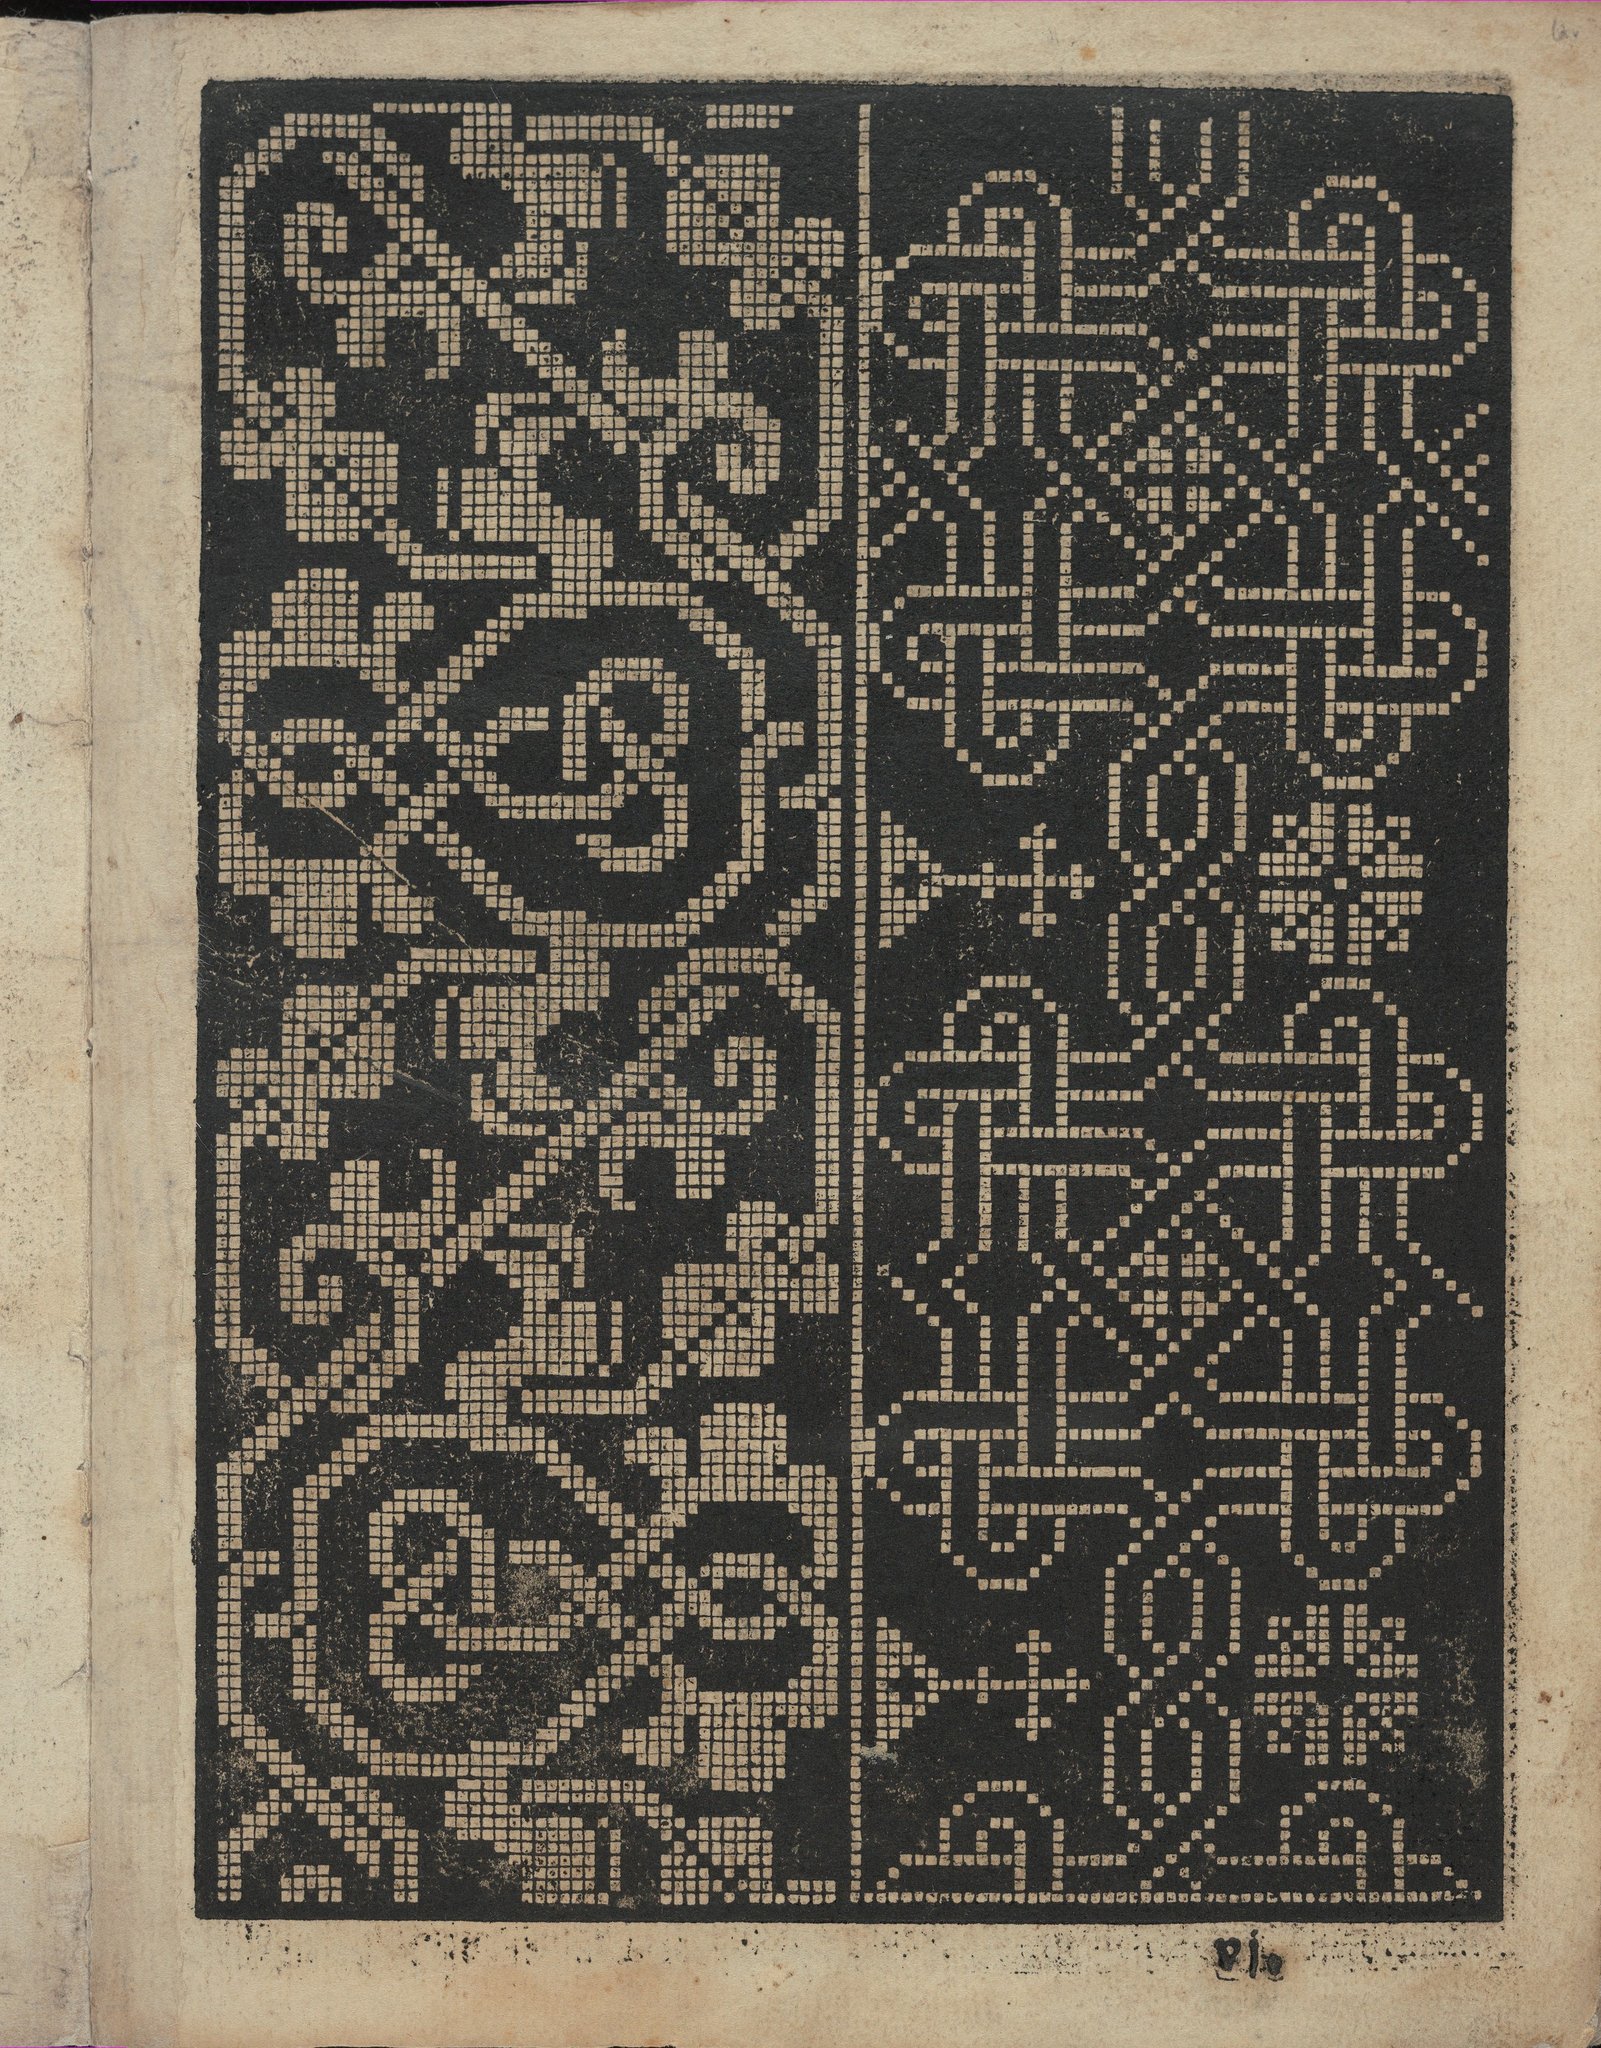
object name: book print ornament architecture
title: Libbretto nouellamete composto per maestro Domenico da Sera...lauorare di ogni sorte di punti, page 6 (recto)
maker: domenico da sera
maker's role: publisher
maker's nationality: french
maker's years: 1500-1599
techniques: woodcut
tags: ornament